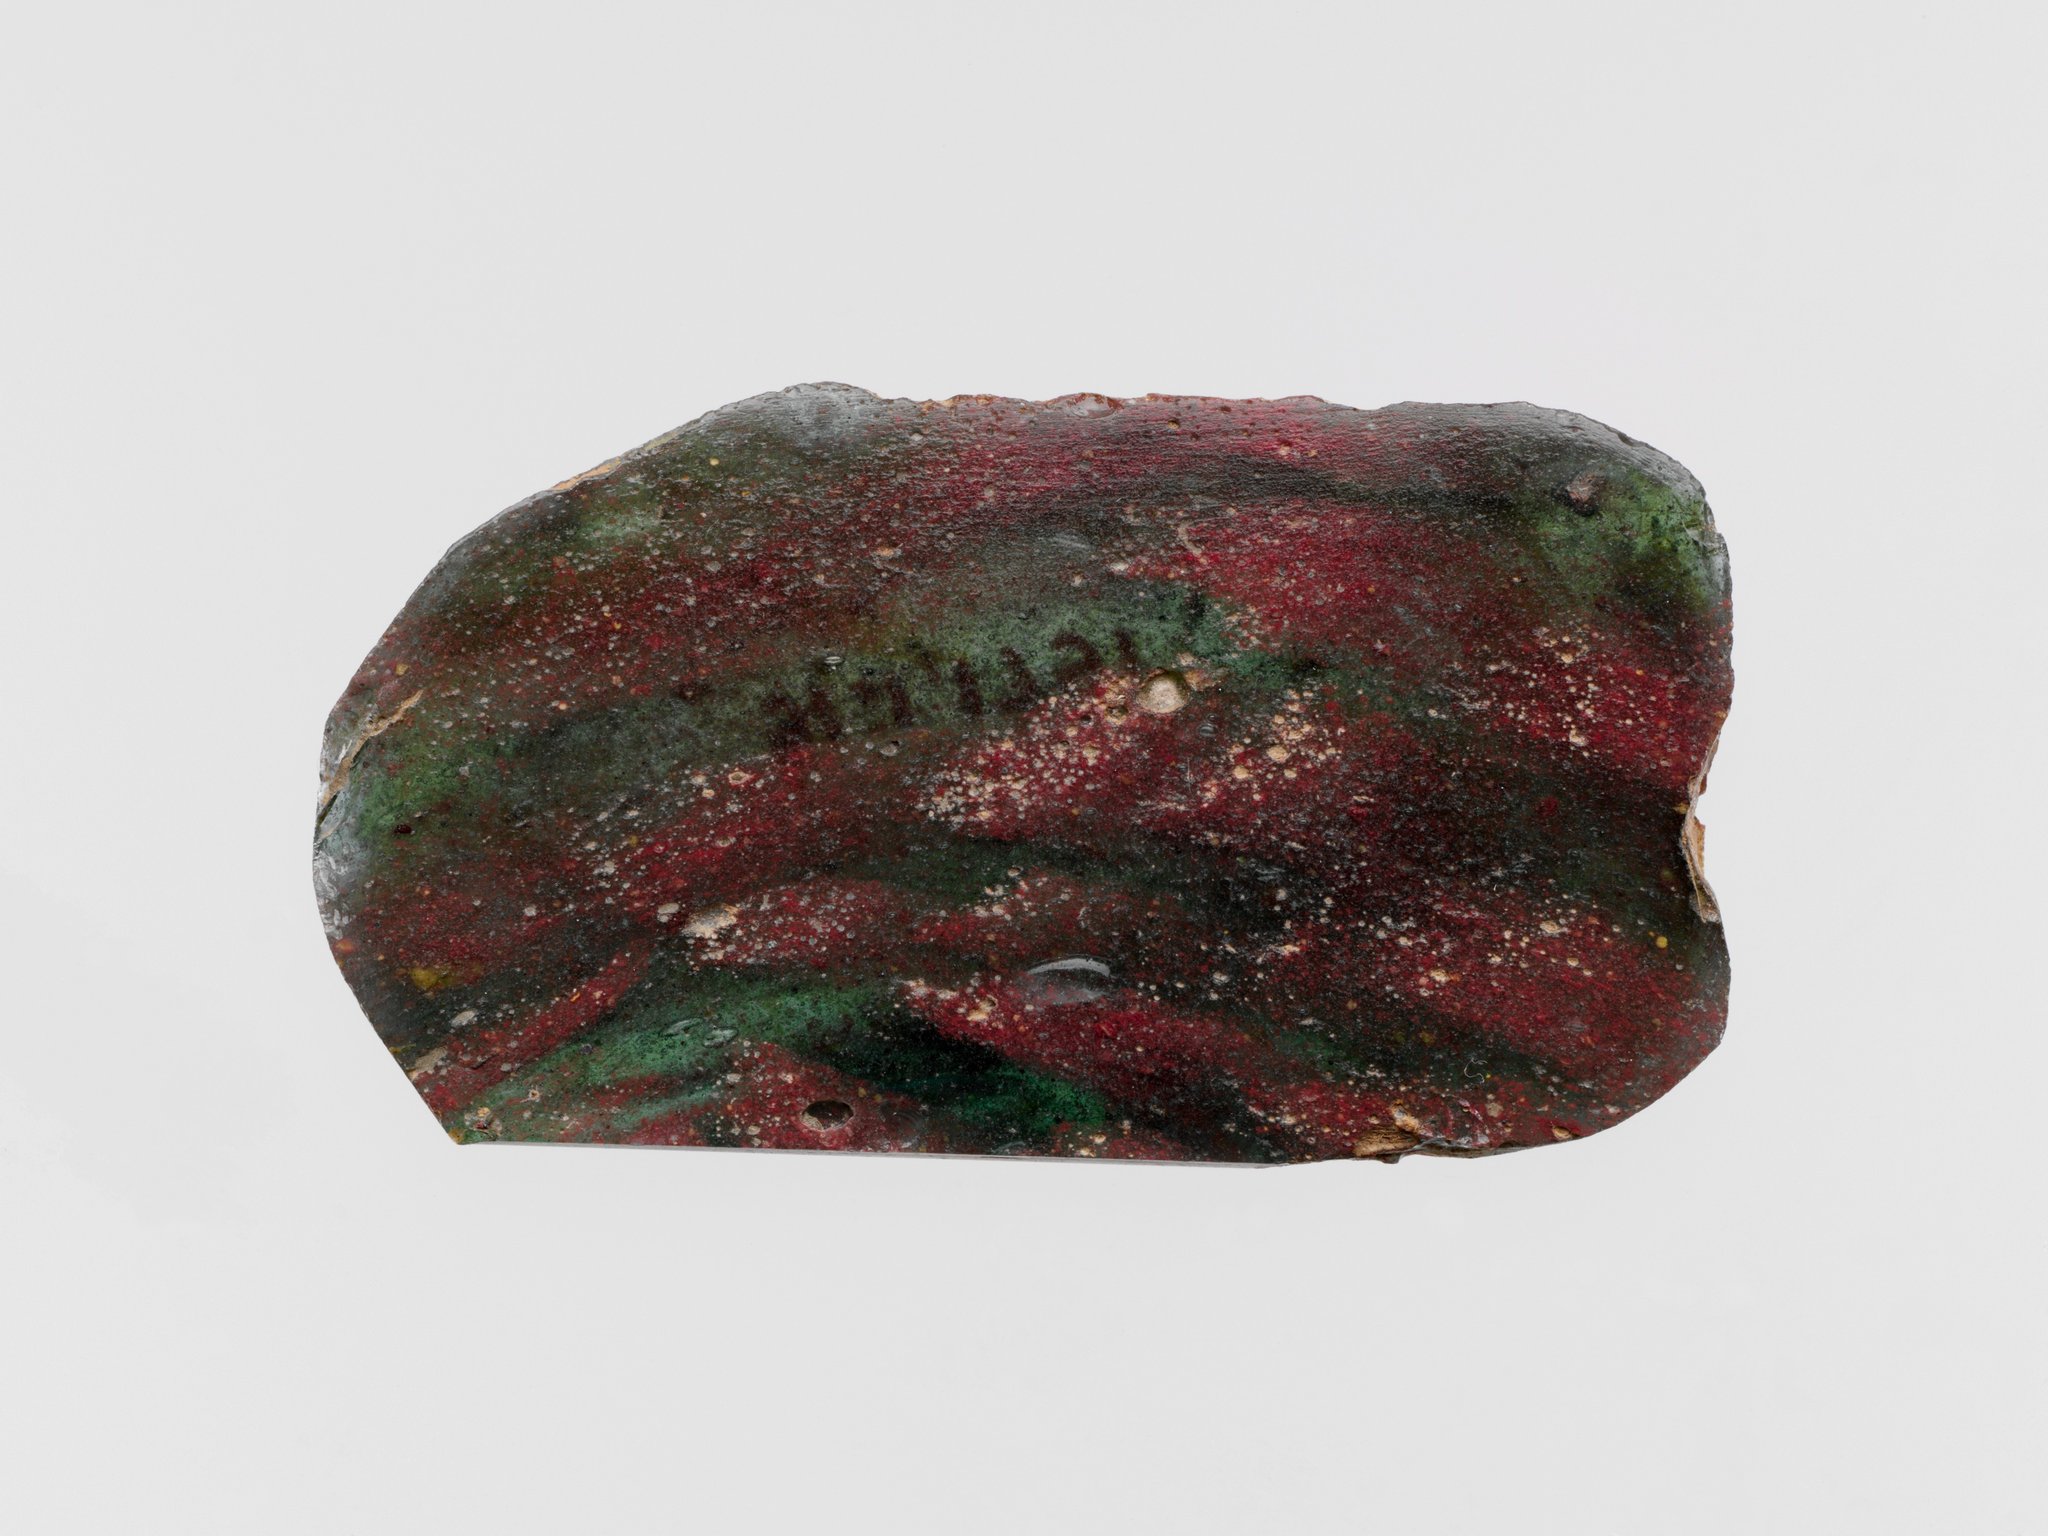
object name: fragment, mosaic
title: Glass mosaic inlay fragment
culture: roman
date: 34 BCE-33 CE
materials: glass